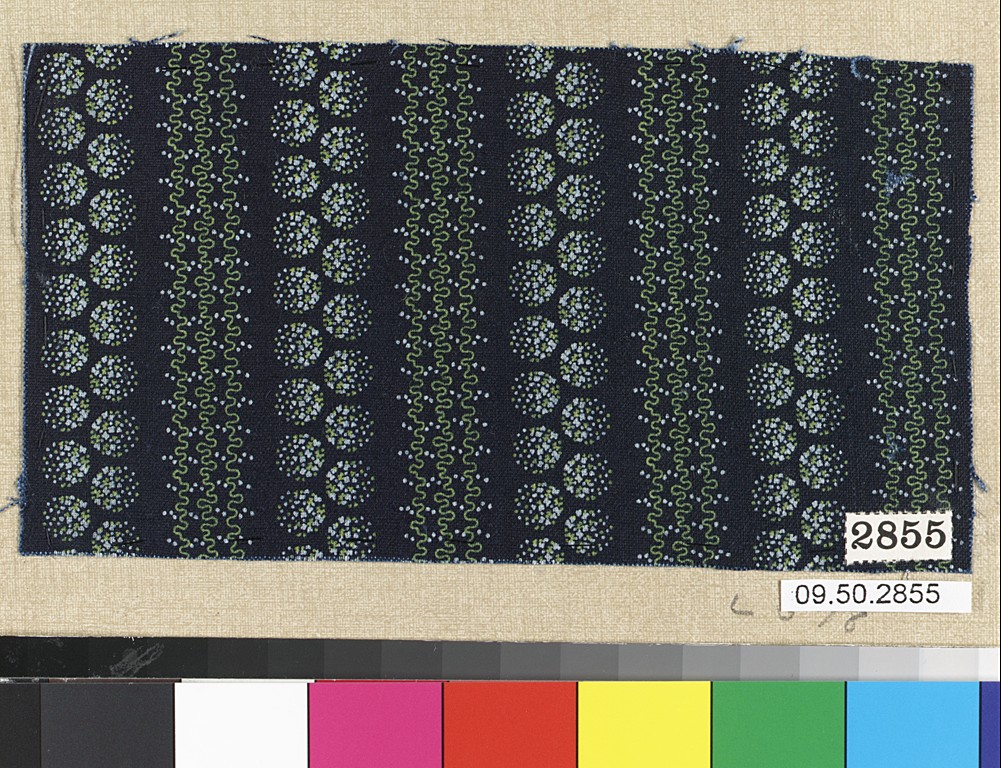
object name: piece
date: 1801-1900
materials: cotton